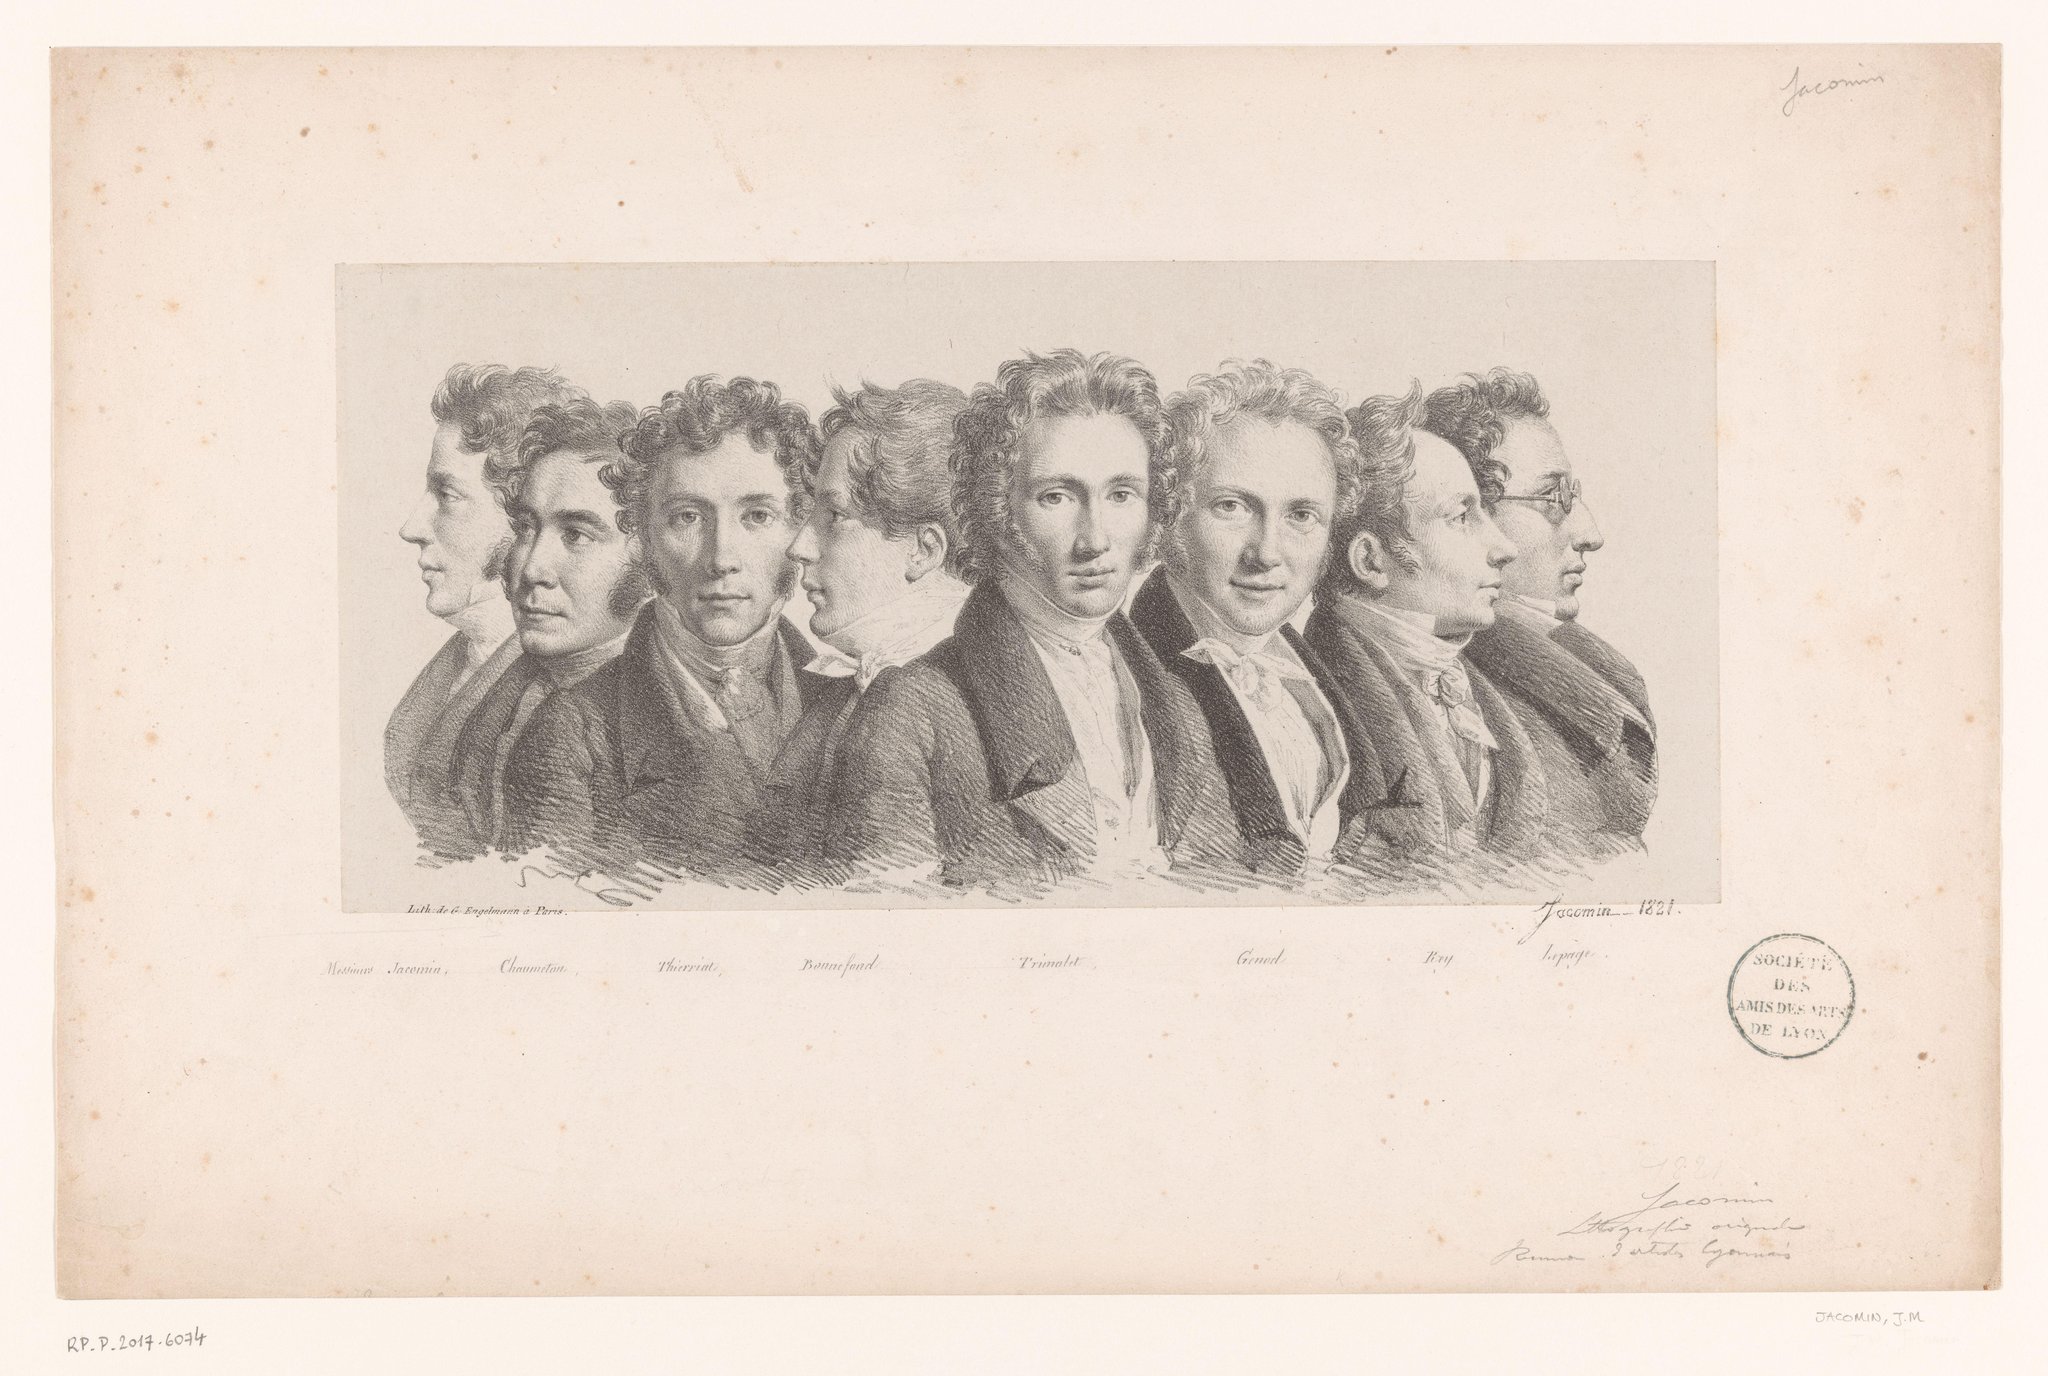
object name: print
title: Groepsportret van acht kunstenaars uit Lyon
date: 1821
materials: paper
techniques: lithograph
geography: paris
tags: jean marie jacomin, painter, michel philibert genod, étienne rey, jean claude bonnefond, lyon, print maker, jean-baptiste chometon, historical persons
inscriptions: stamp: ‘Société des Amis des Arts de Lyon’ Lugt 4945, collector's mark: Lugt 2228